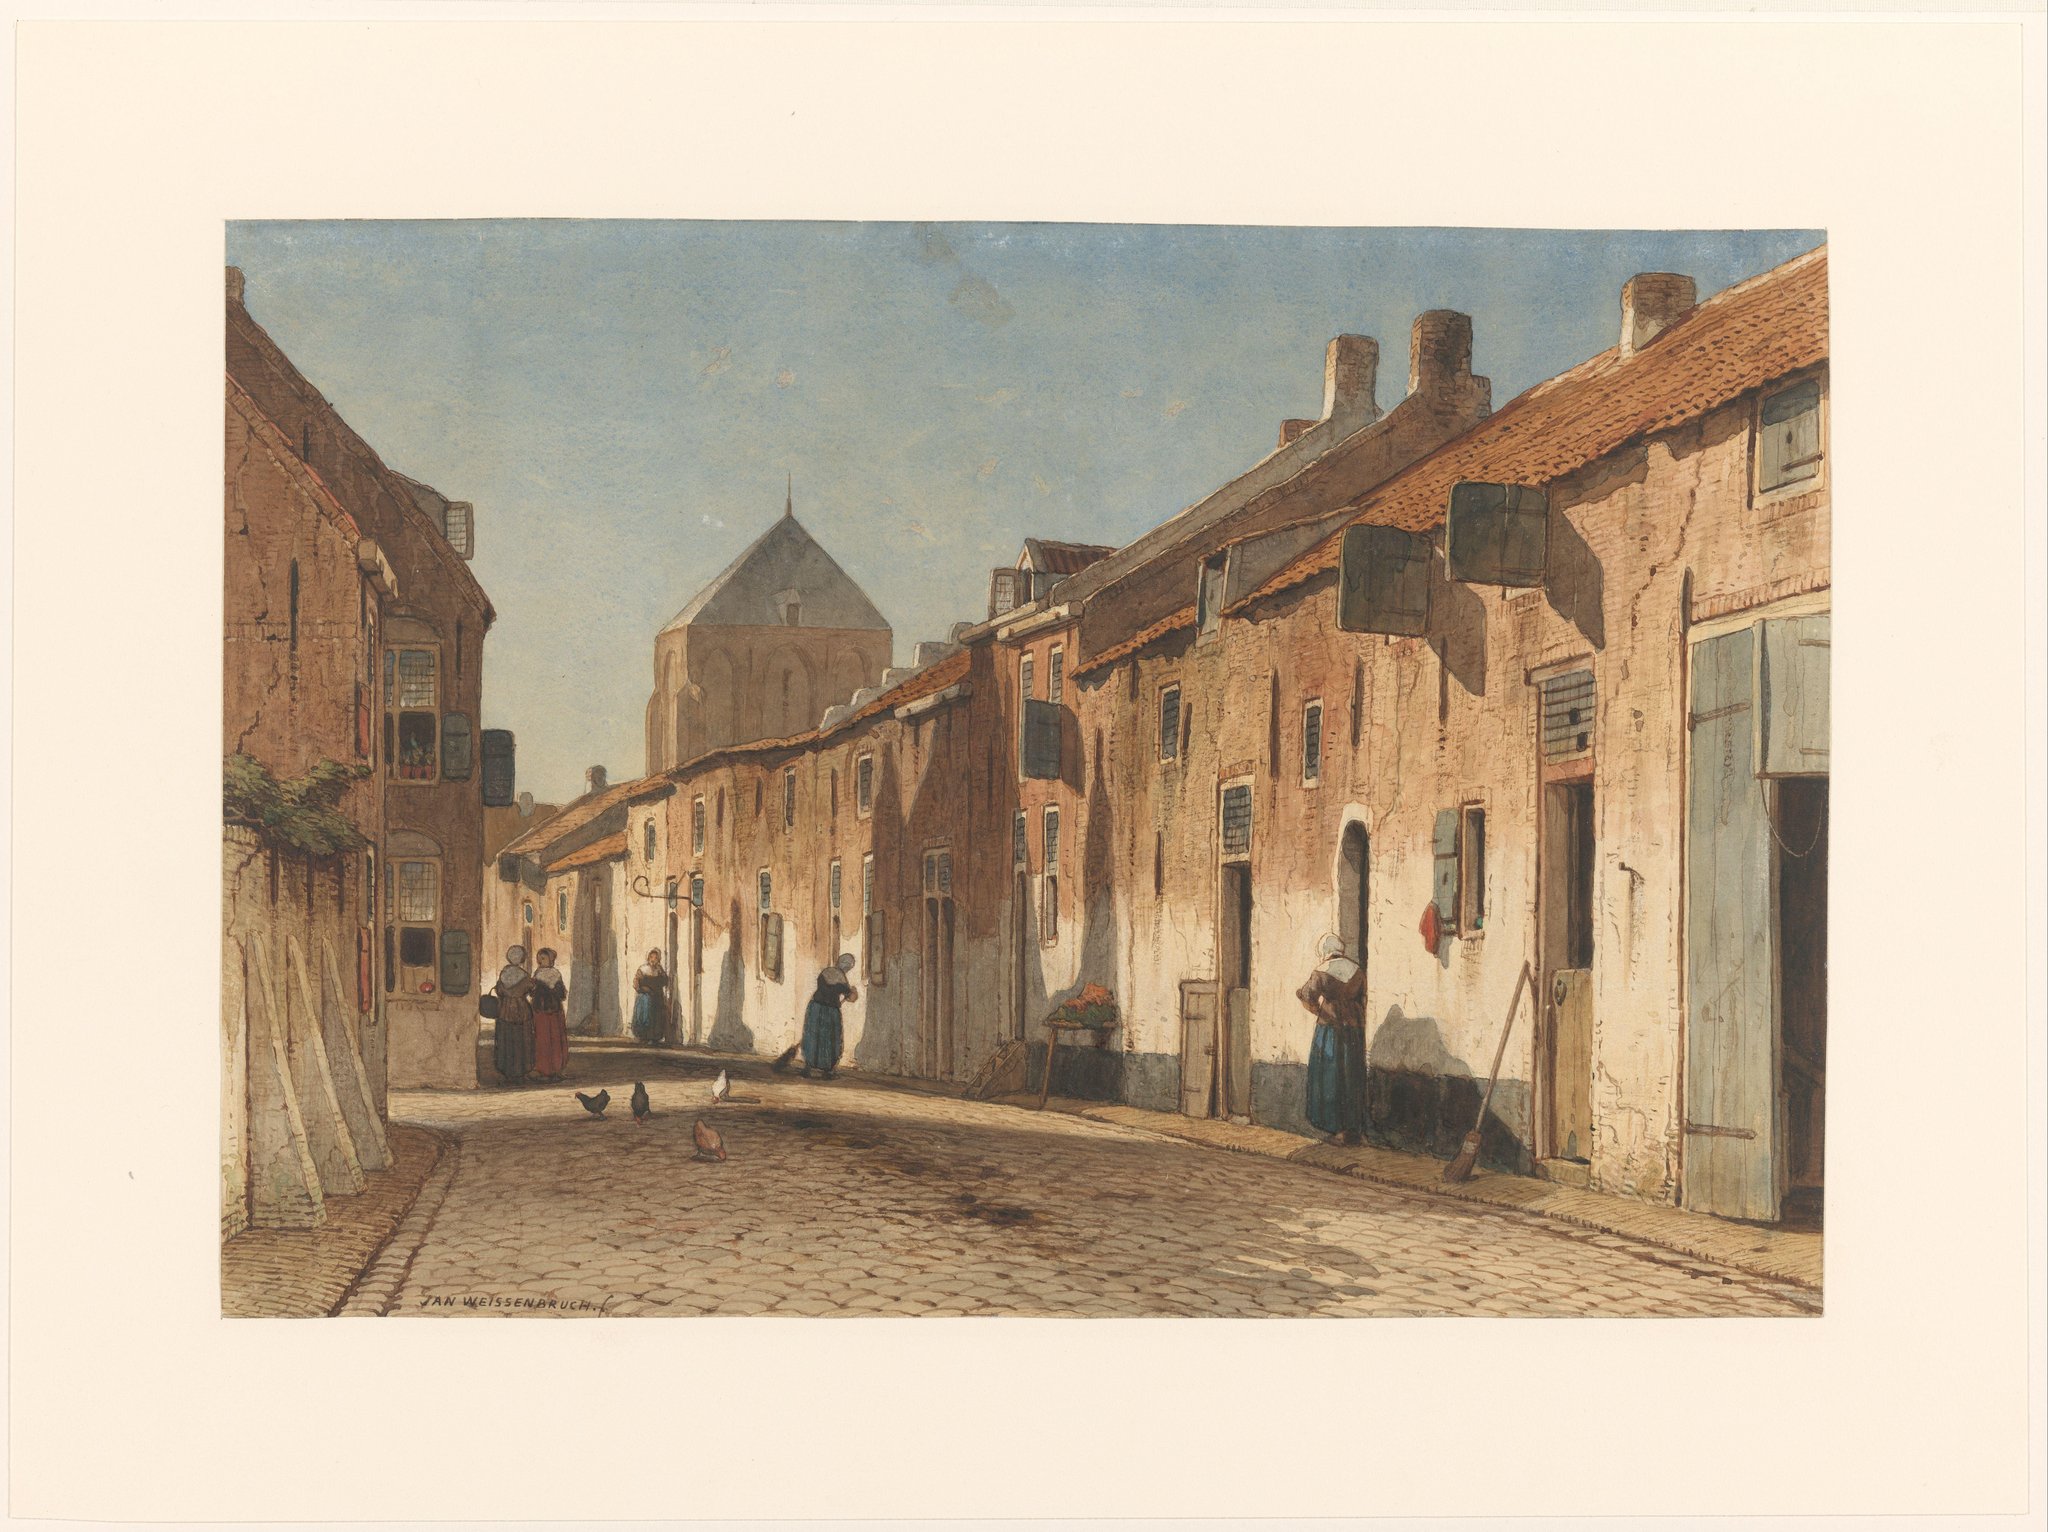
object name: drawing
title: Dorpsstraat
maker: jan weissenbruch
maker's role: painter, print maker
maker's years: 1822-1880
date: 1832-1880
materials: paper, watercolor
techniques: brush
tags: public road in village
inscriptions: collector's mark: Lugt 2228